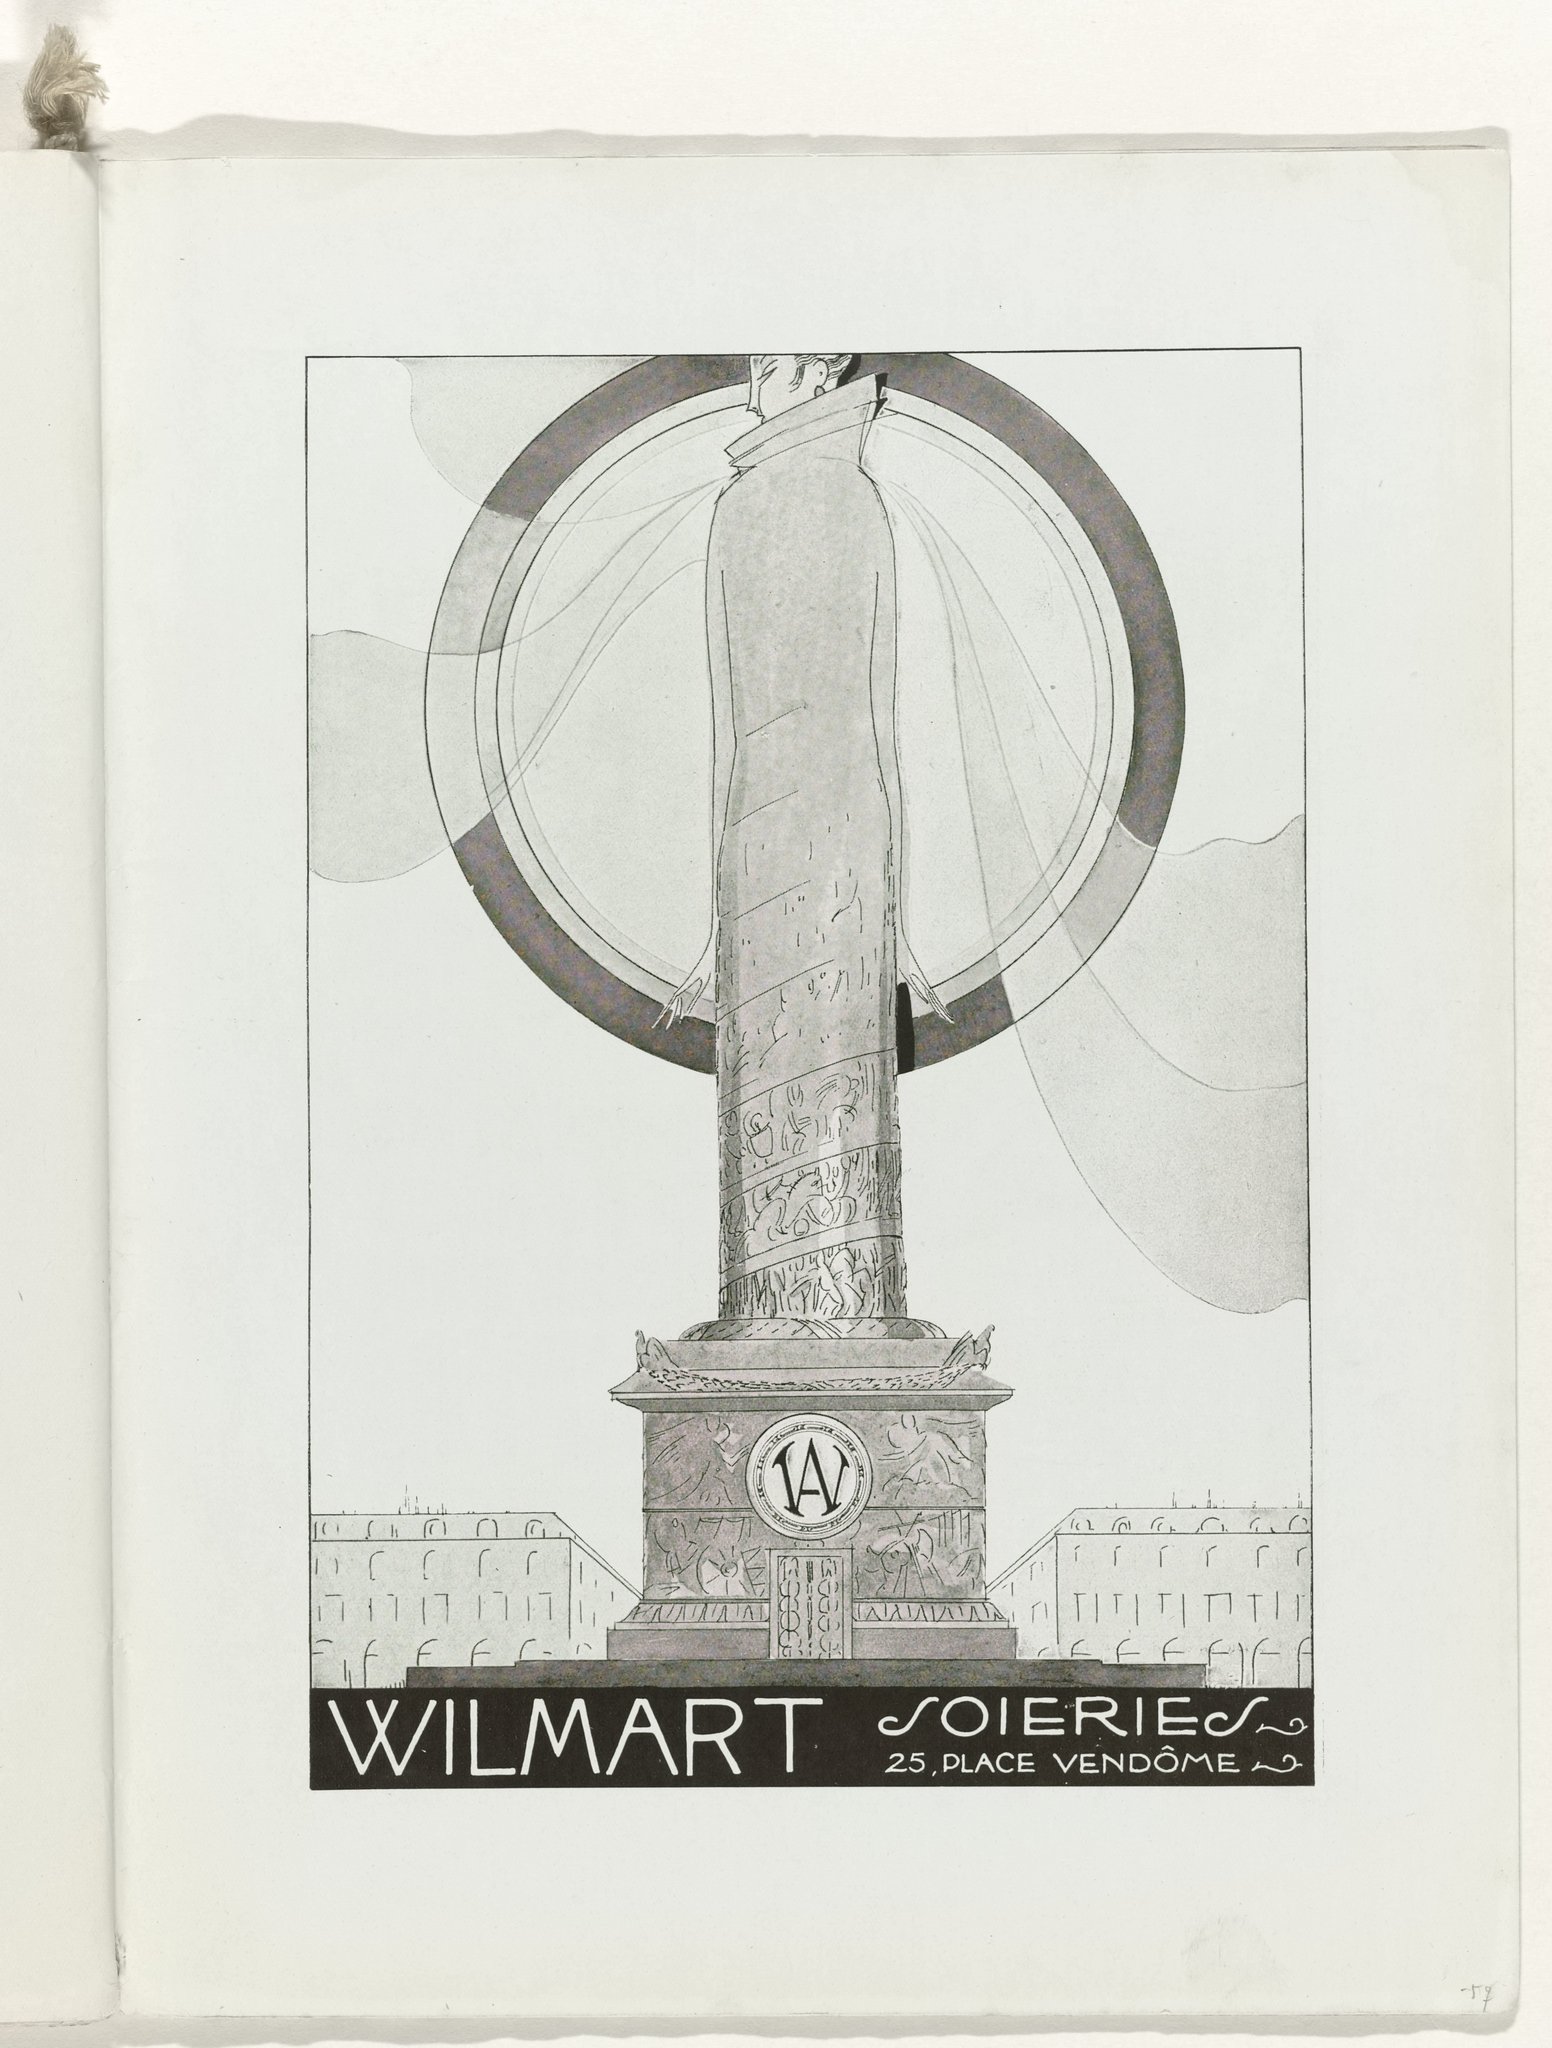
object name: fashion print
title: Art - Goût - Beauté, Feuillets de l' élégance féminine, Noël 1928, No. 100, 9e Année, p. 57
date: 1928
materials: paper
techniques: photography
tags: fashion plates, textile fabric, cloth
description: Advertentie voor stoffen van Wilmart. Pagina uit het modetijdschrift Art-Goût-Beauté (1920-1933).